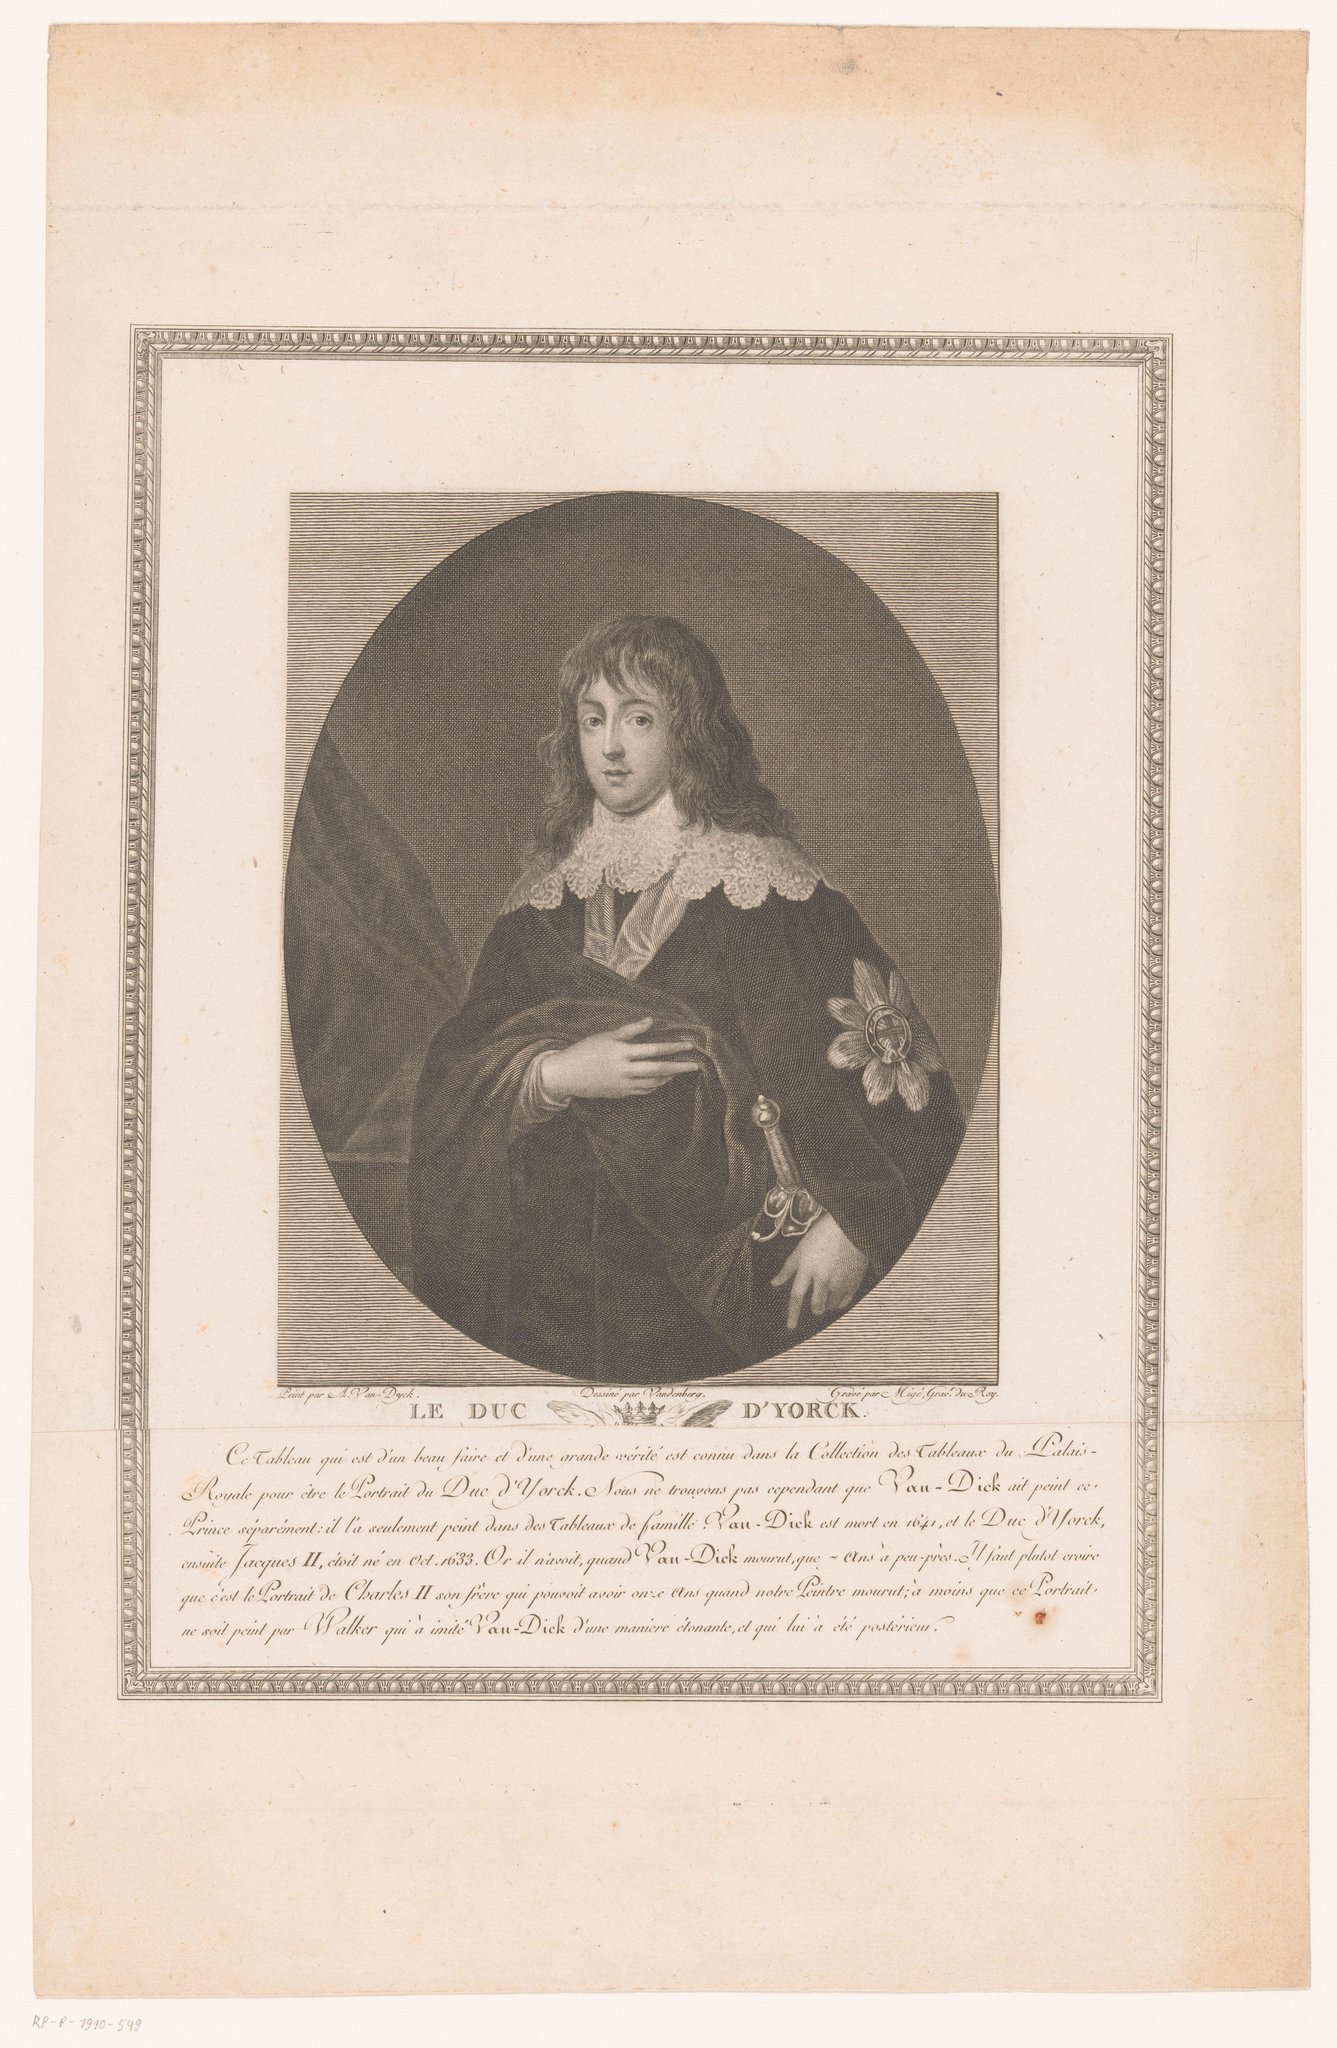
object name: print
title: Le duc d'Yorck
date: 1786-1808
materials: paper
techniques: engraving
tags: jacobus ii (koning van engeland en schotland), historical persons, ruler, sovereign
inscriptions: collector's mark: Lugt 2228